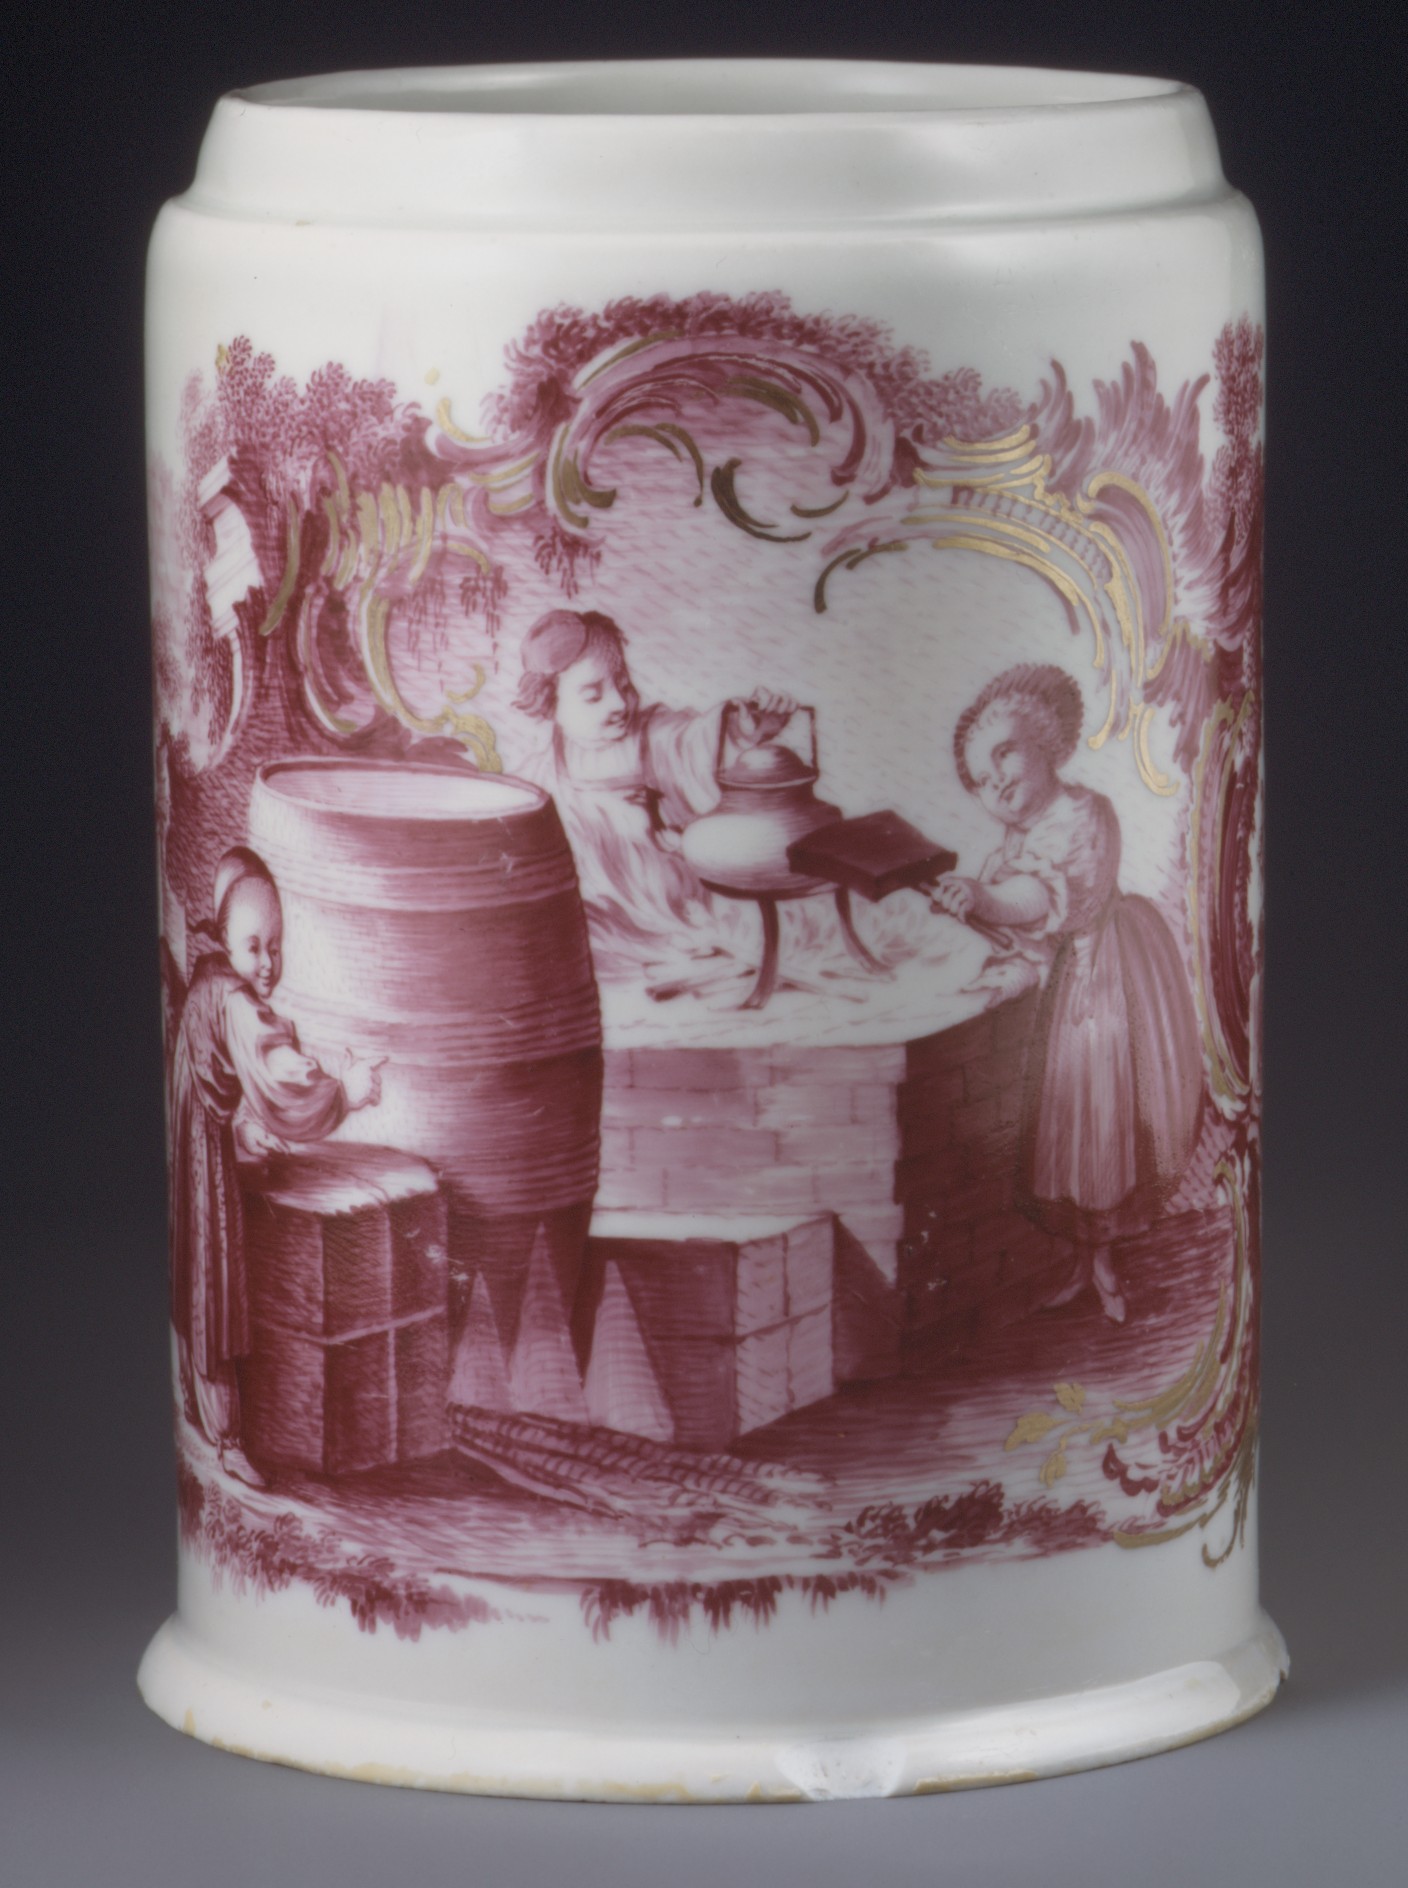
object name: mug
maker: fulda pottery and porcelain manufactory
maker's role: manufactory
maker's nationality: german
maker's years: 1764-1789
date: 1770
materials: hard paste porcelain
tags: boys,girls,women